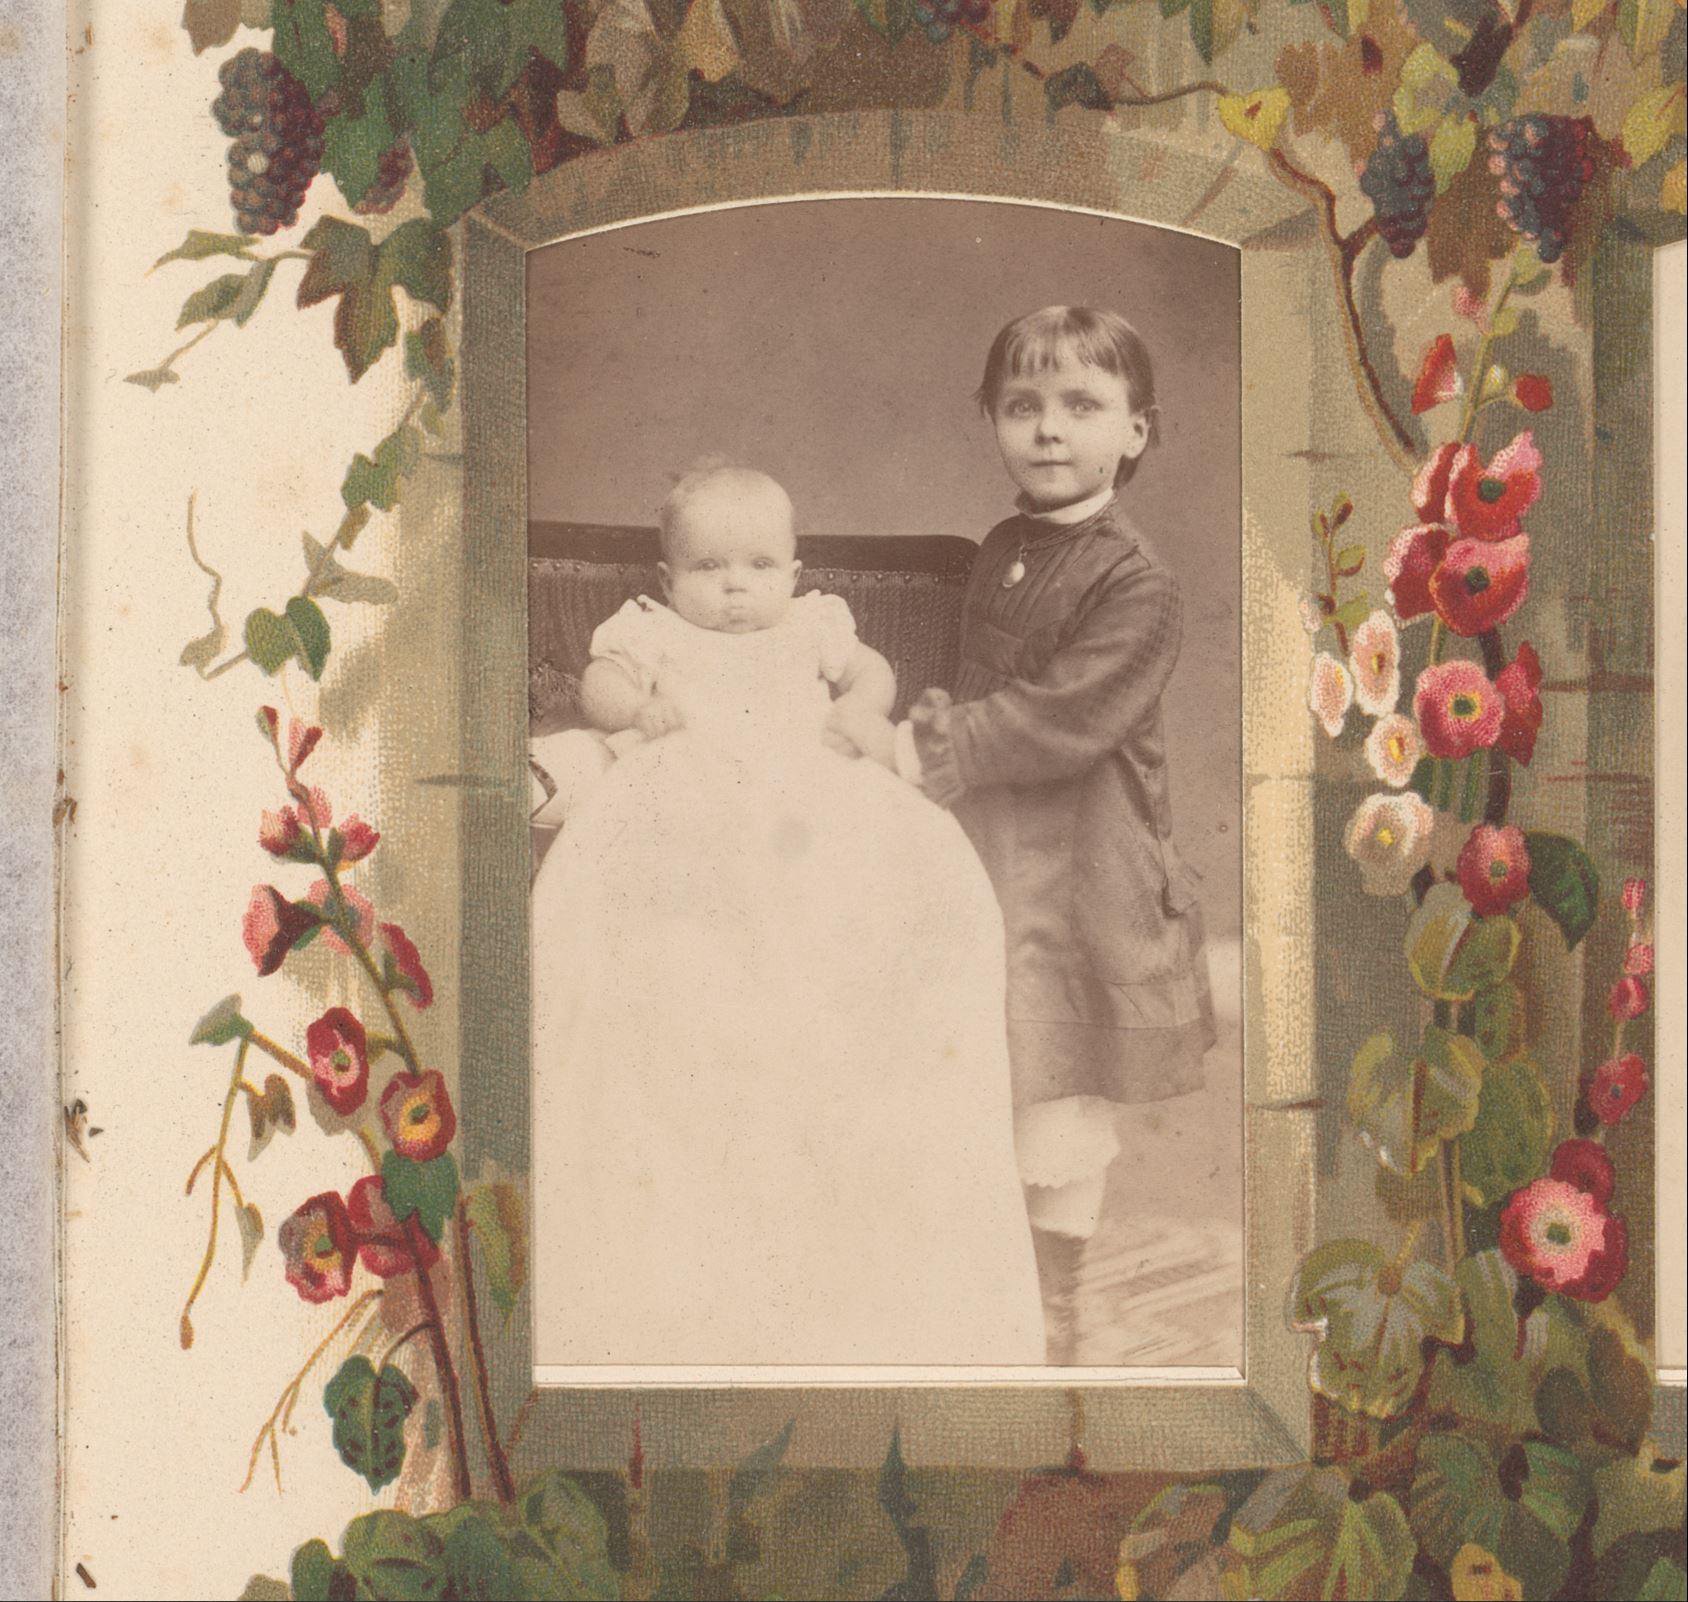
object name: photograph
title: Portret van een jong kind en een baby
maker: julius jr. ortgies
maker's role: fotograaf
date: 1850-1900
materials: cardboard, photographic support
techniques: albumen print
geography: germany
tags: historical persons, girl (child between toddler and youth), infant, baby ~ the ages of man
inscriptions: annotation: ‘Mutter [.] Berta Sch[ät]ze’, inscription: ‘Photographie/ Atelier/ von/ Jul. Ortgies Jr./ BREMEN/ 116, am Wall 116,/ (früher Wall 160)/ zwischen dem Ansgarii-u. Heerdenthor./ Zu Nachbestellungen wird die Originalplatte aufbewahrt.’